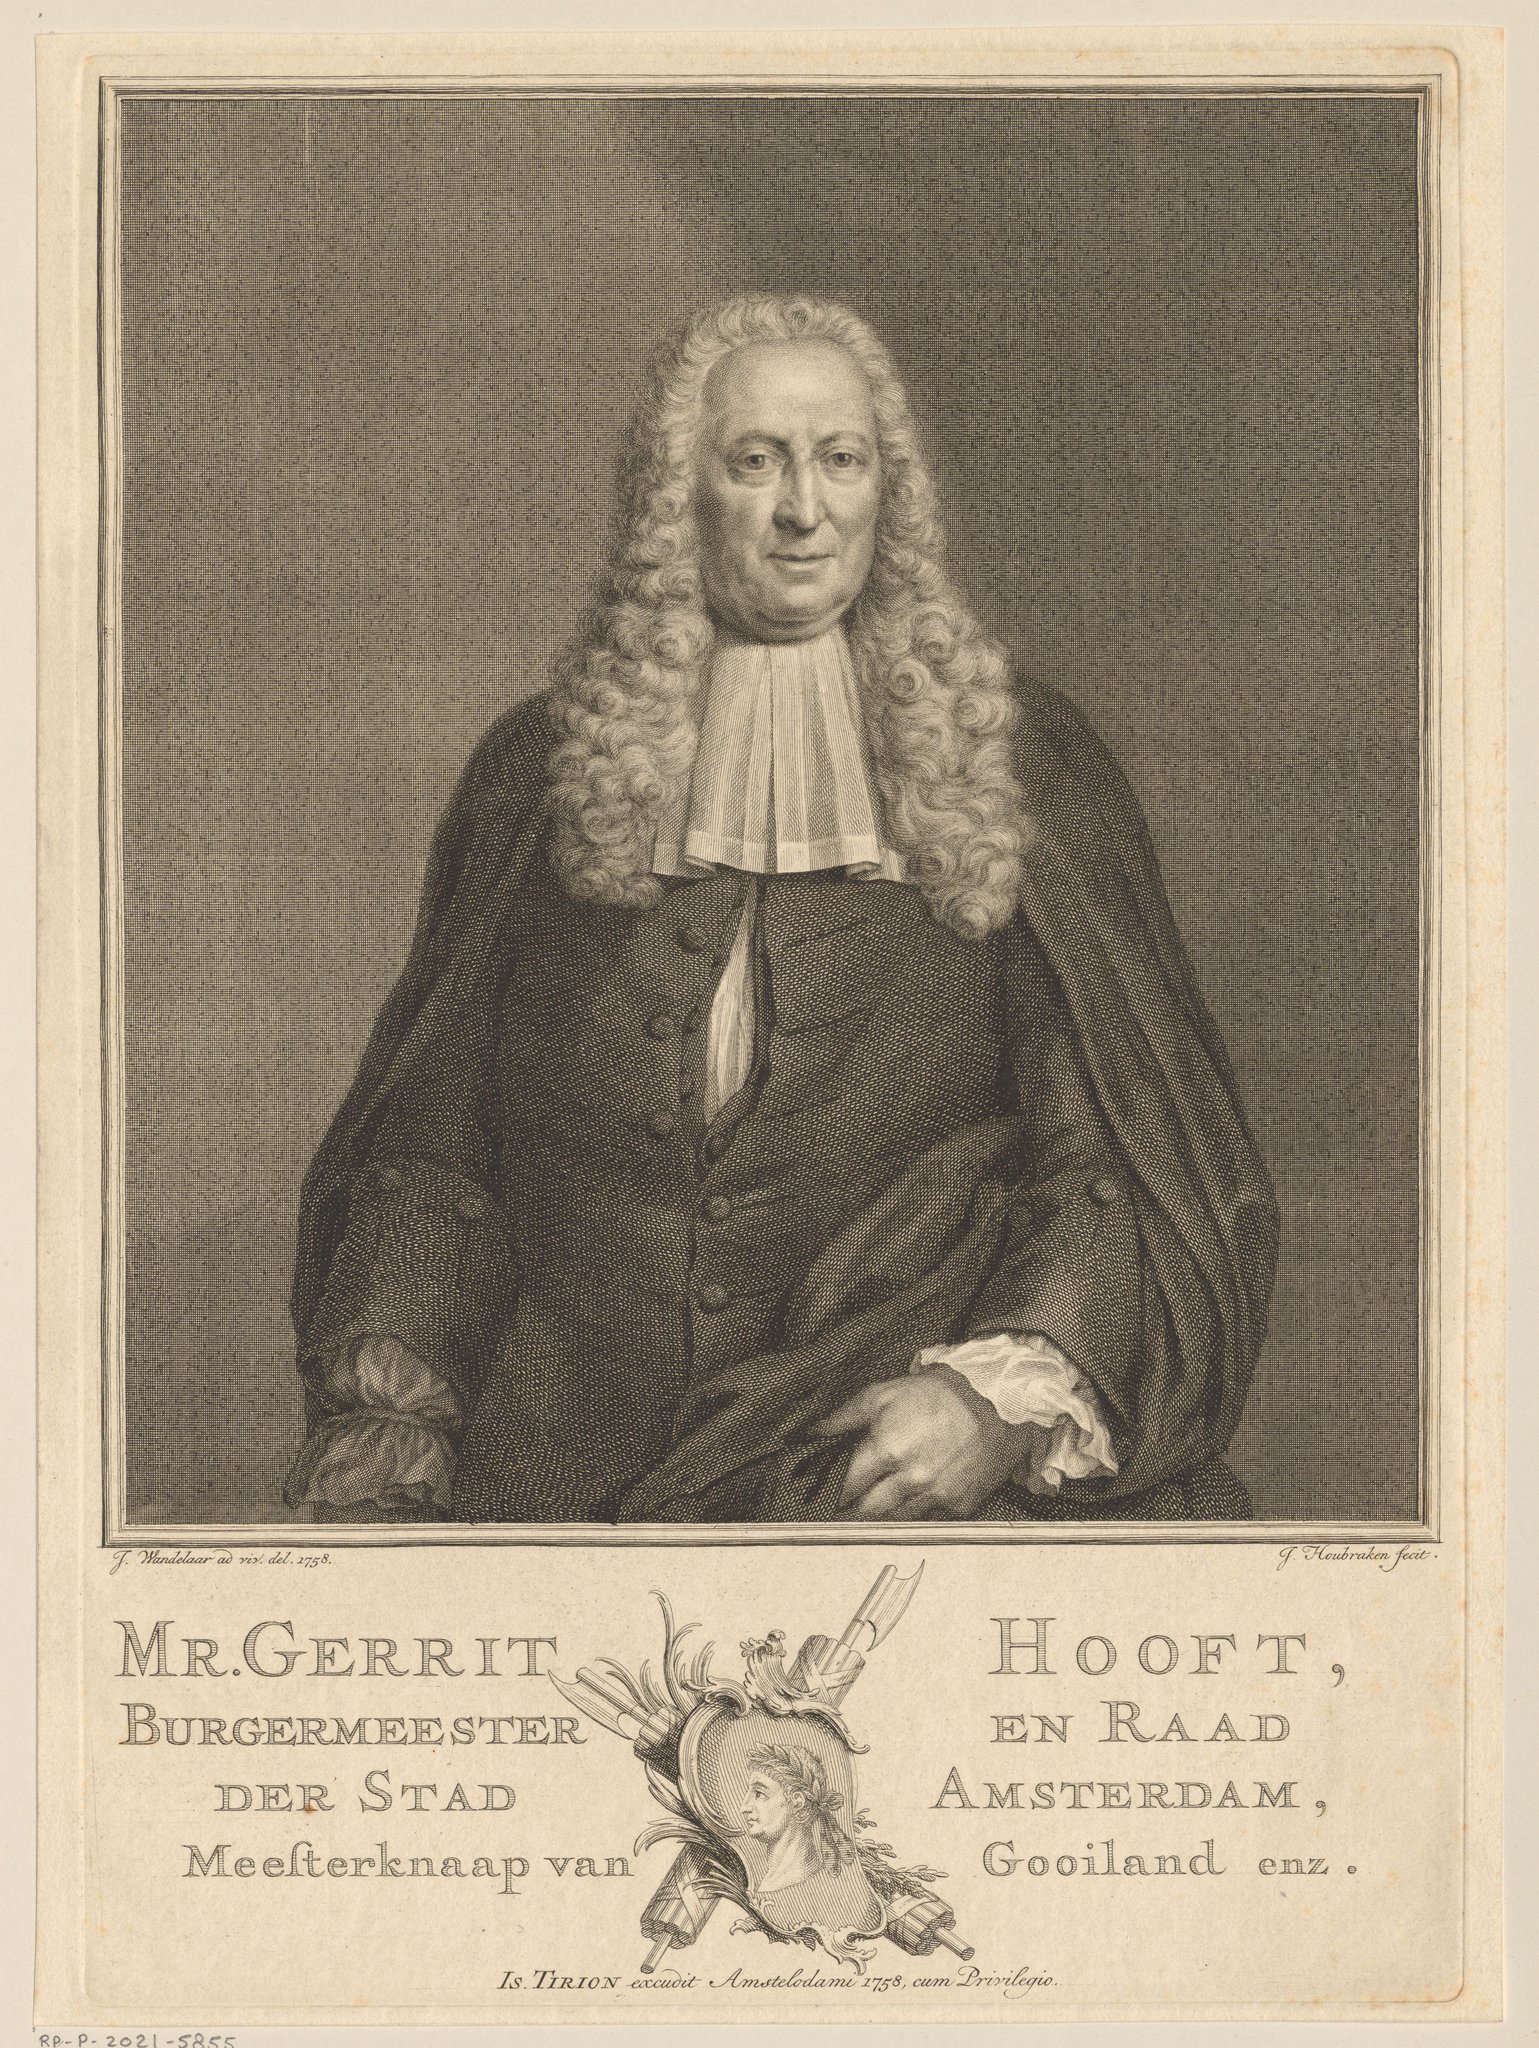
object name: print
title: Portret van Gerrit Hooft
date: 1758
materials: paper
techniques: engraving, etching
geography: amsterdam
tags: amsterdam, mayor, burgomaster, historical persons, armorial bearing, heraldry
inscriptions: date